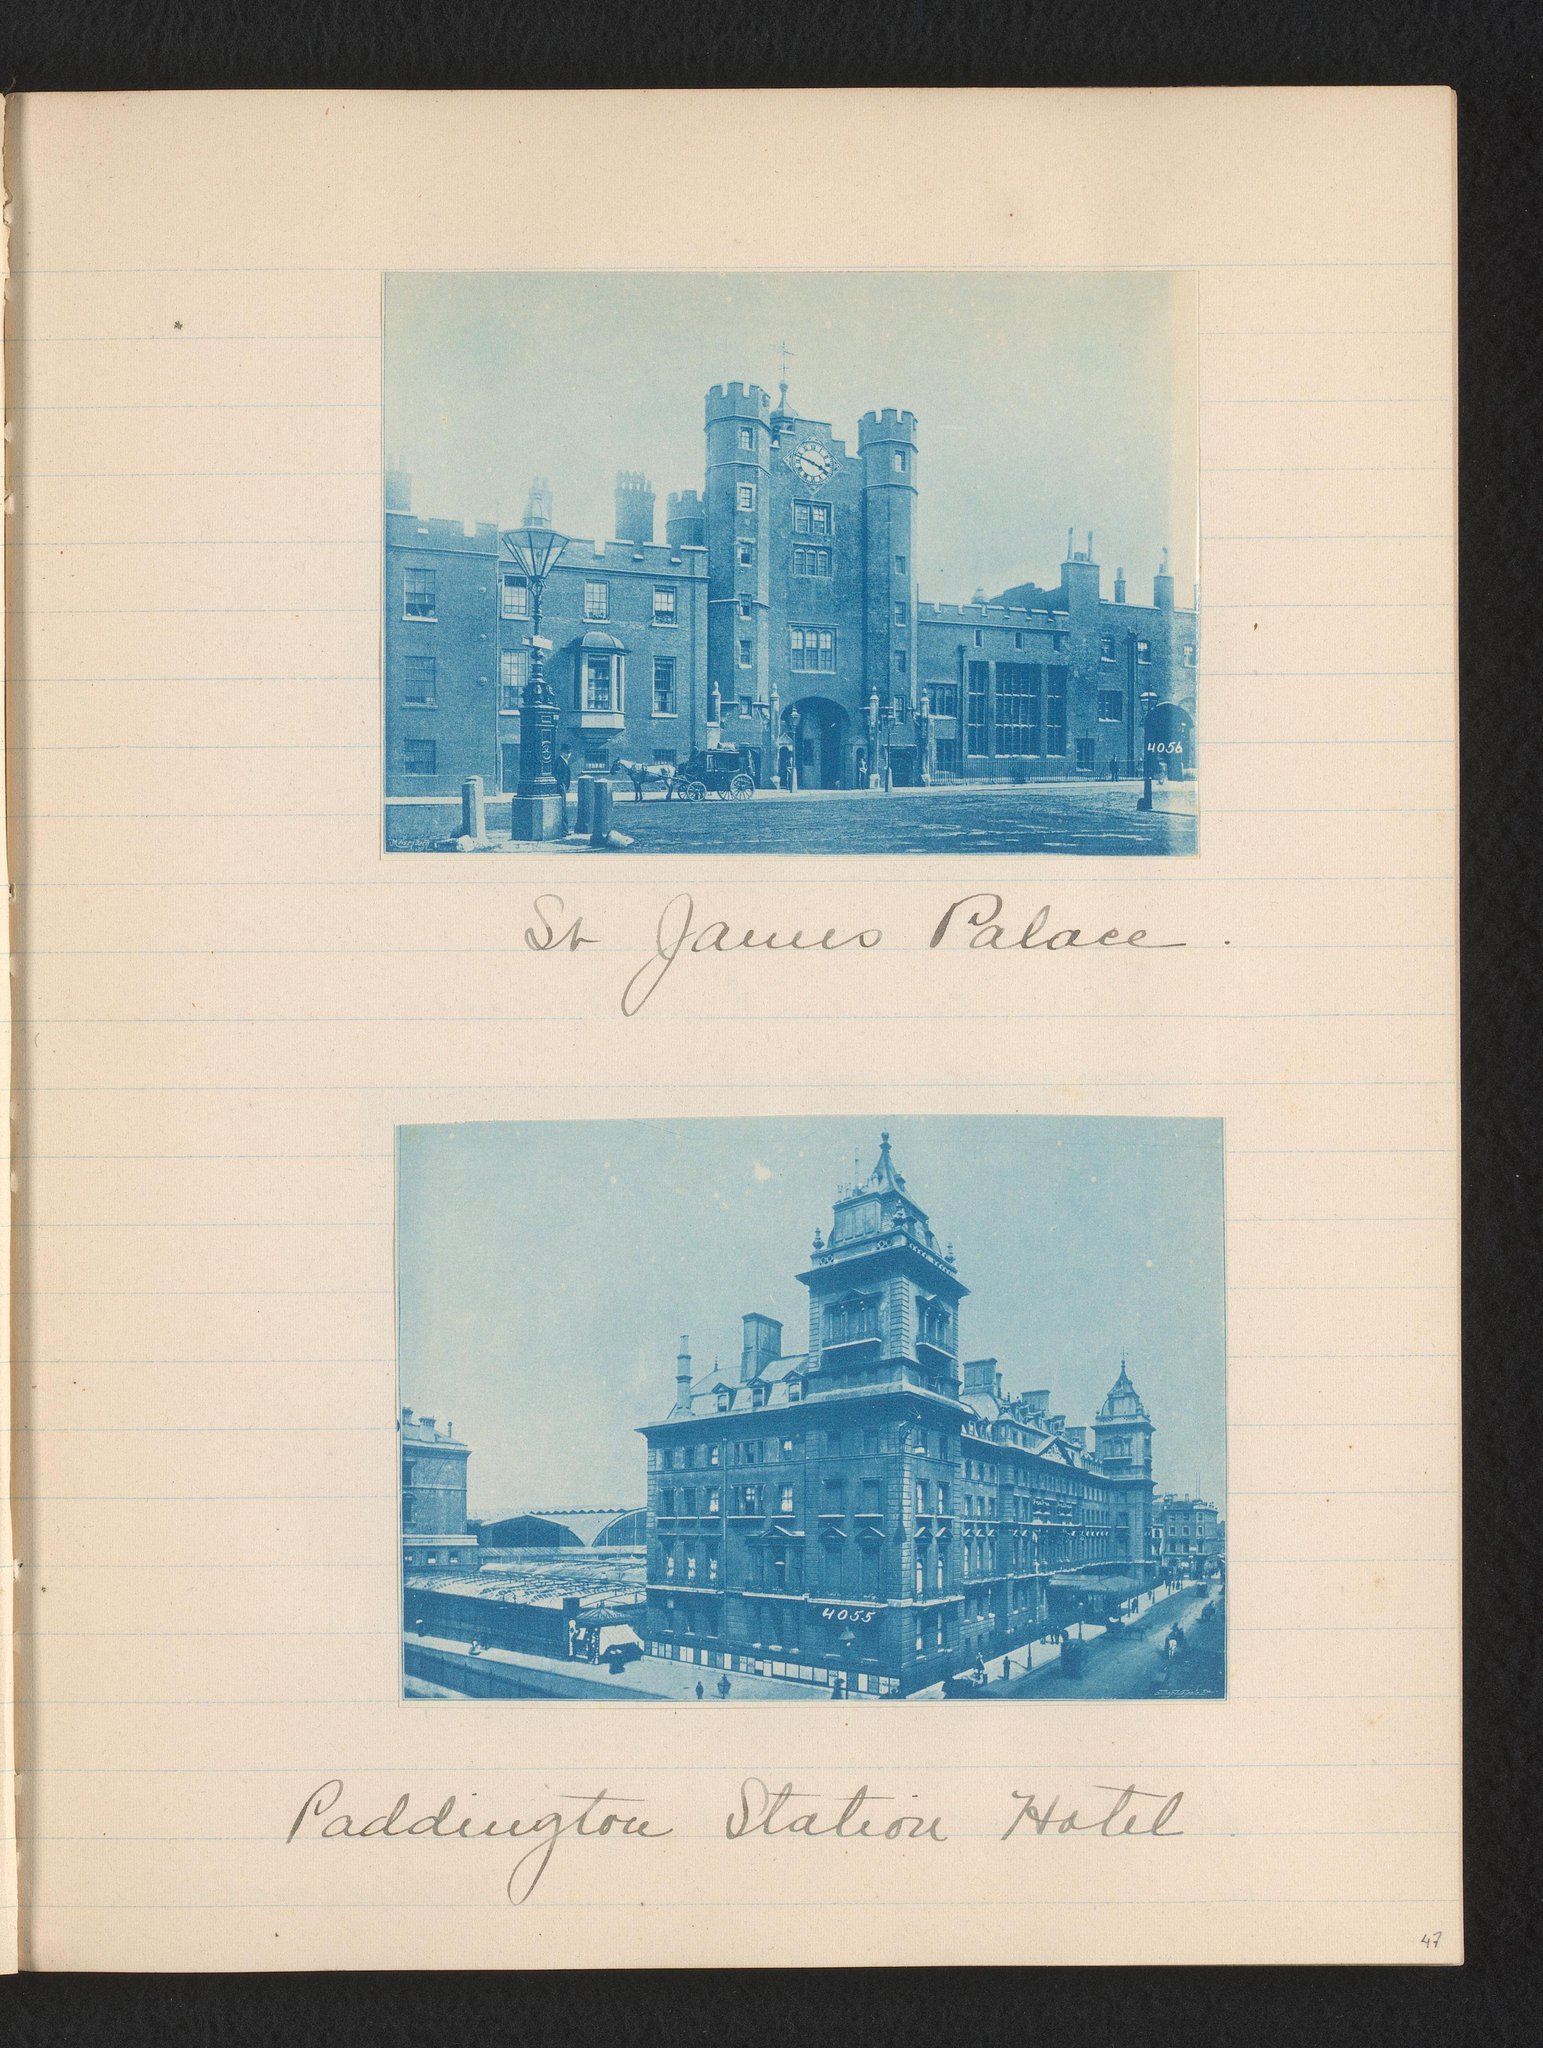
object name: photograph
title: Twee foto's van Saint James's Palace en Paddington Station Hotel, Londen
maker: Anonymous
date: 1901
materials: paper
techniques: cyanotype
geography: london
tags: palace, hotel, hostelry, inn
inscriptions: inscription: ‘St James Palace/ Paddington Station Hotel’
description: Deze foto's maken deel uit van een album.